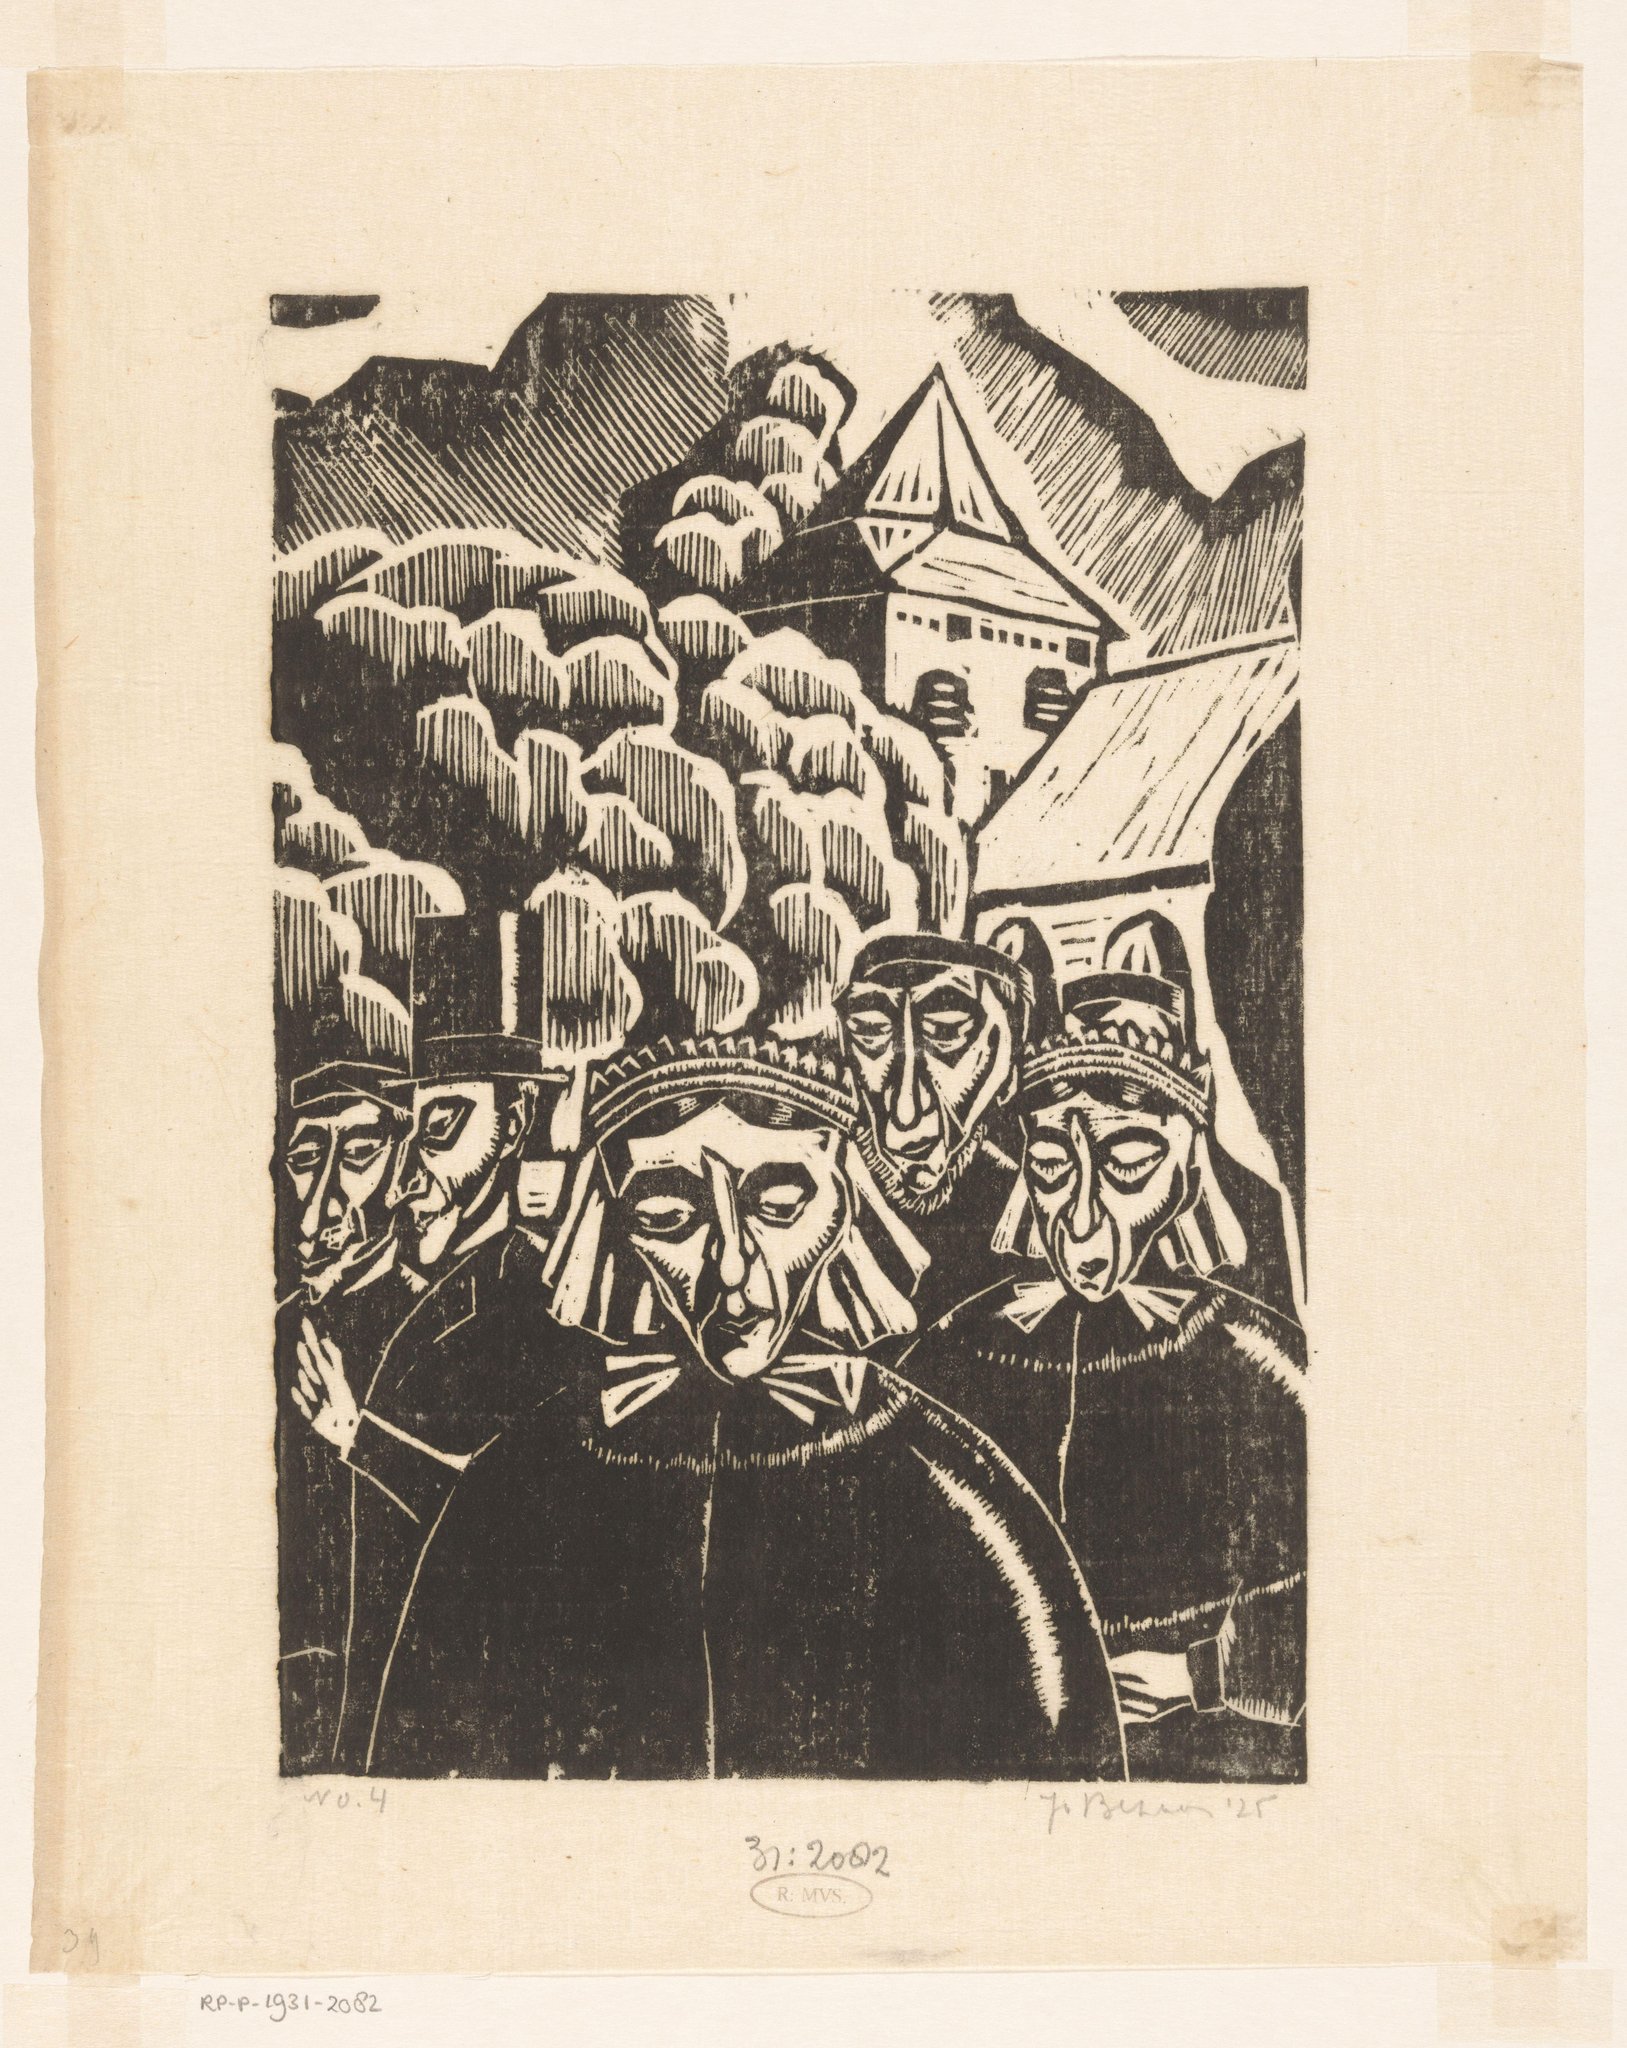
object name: print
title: Kerkgang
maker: jo bezaan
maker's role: draughtsman, print maker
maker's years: 1894-1952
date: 1925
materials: paper, ink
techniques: woodcut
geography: putten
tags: going to church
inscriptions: collector's mark: Lugt 2228, number: ‘No. 4’, signature and date: ‘Jo Bezaan '25’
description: Twee vrouwen en drie mannen met vrome gezichten voor een kerk.